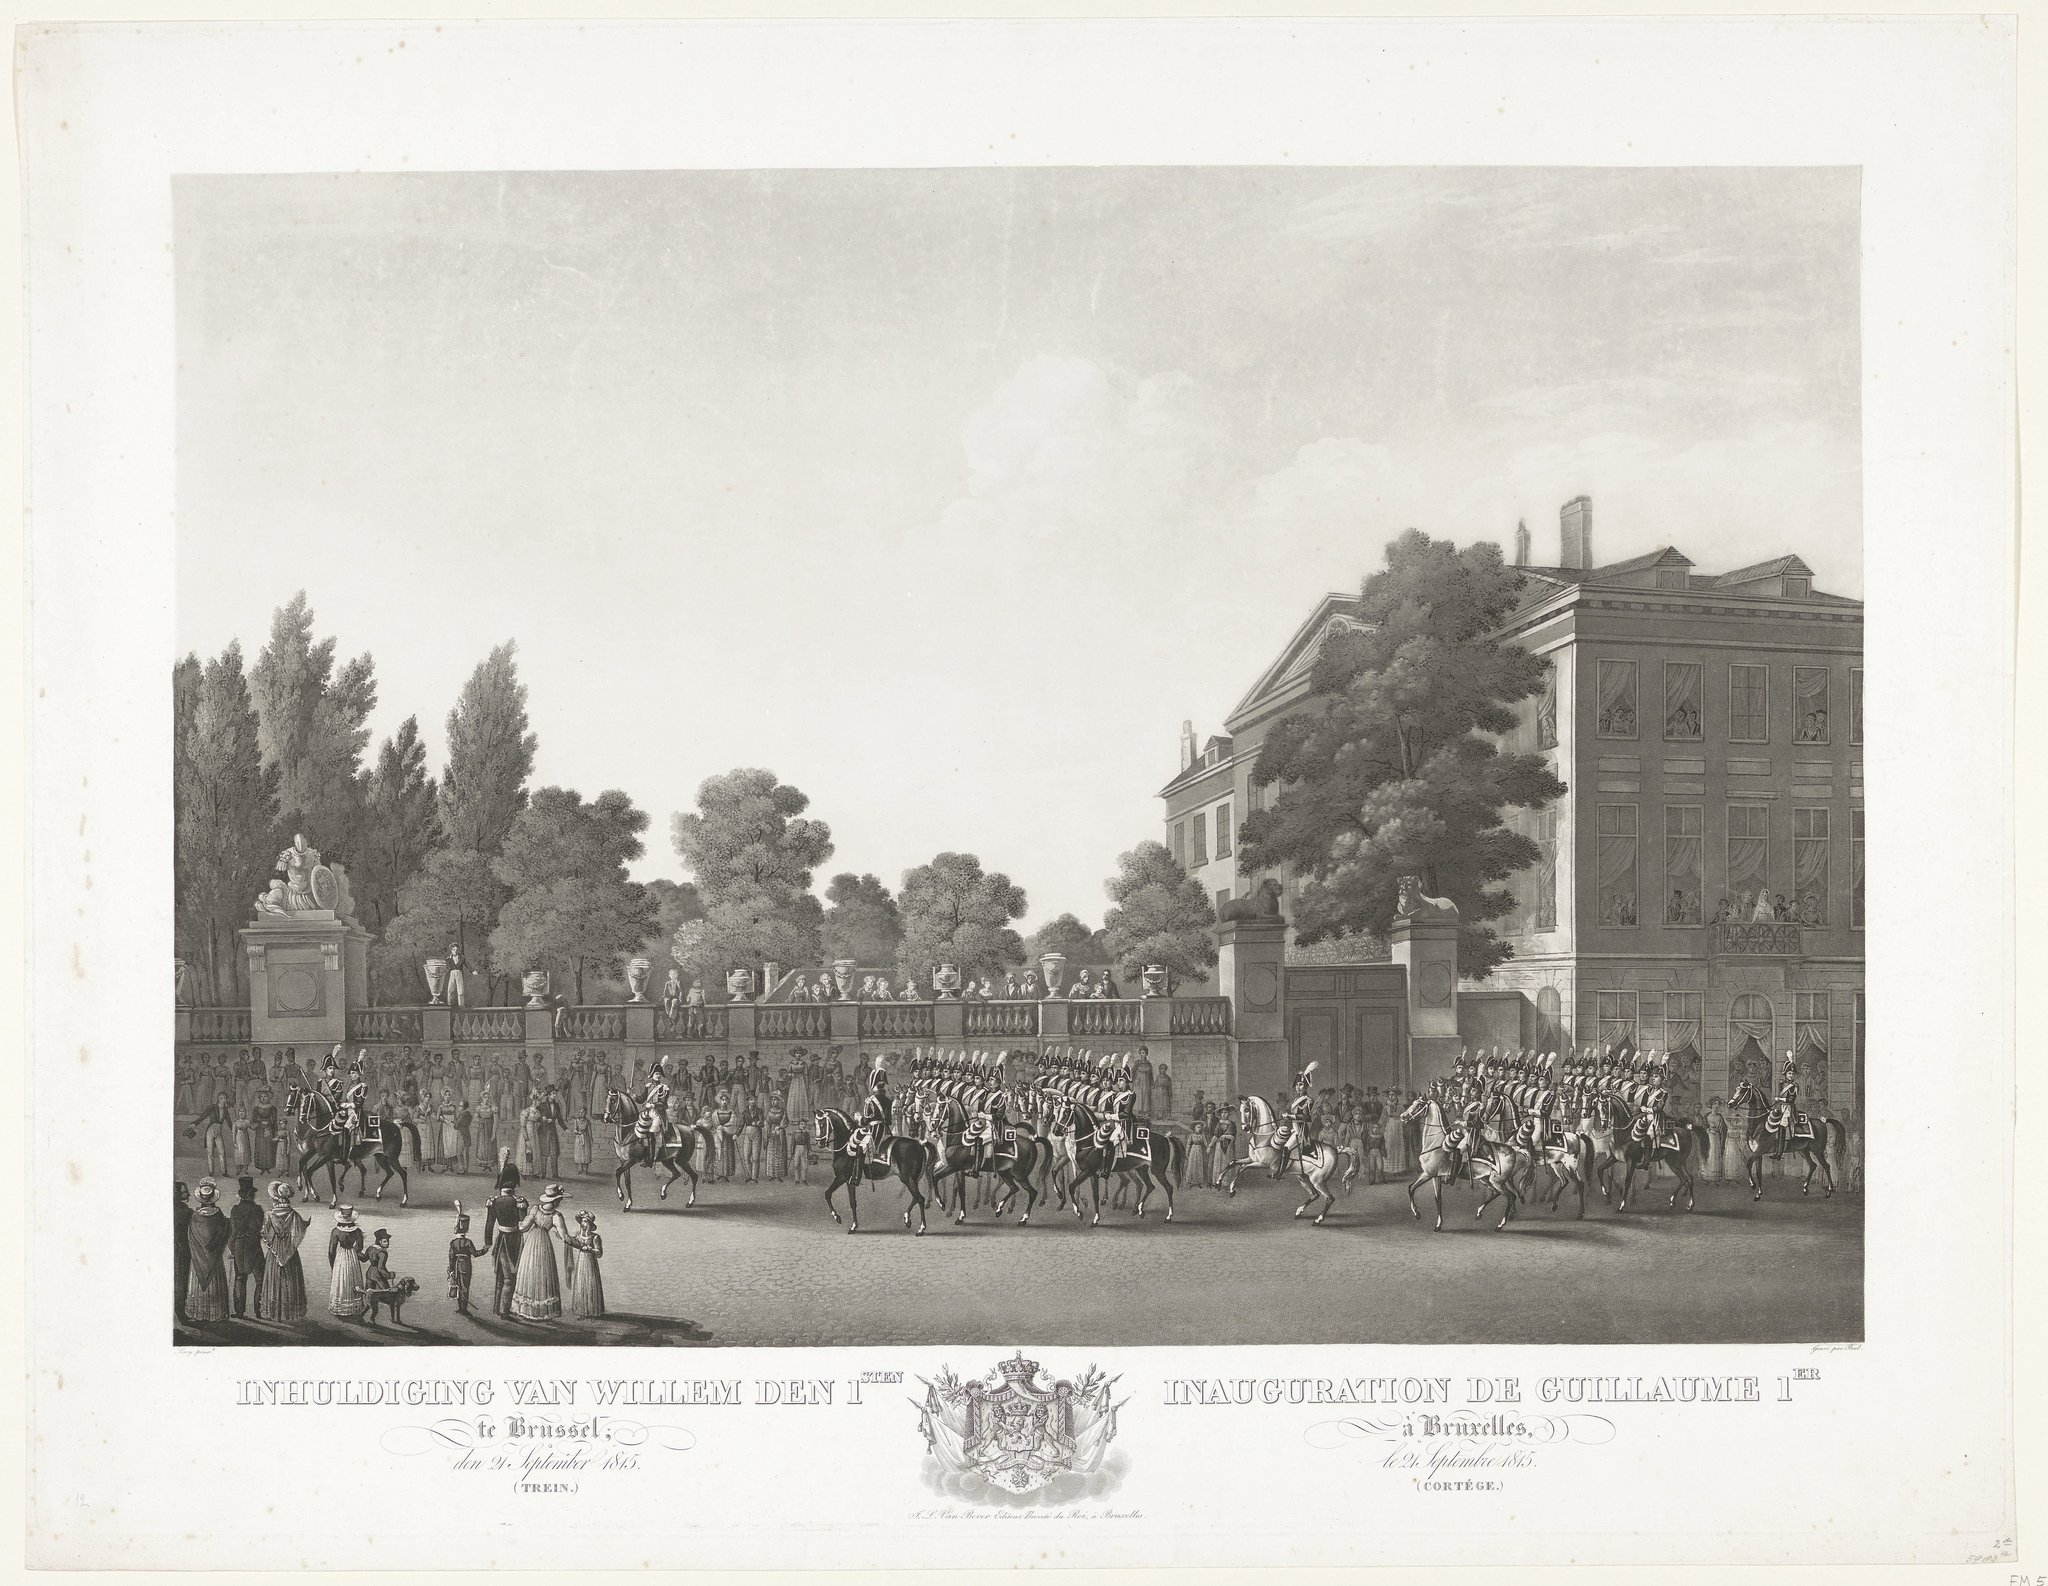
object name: print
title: Inhuldiging van Willem den 1sten te Brussel, den 21 September 1815 (Trein.) / Inauguration de Guillaume 1er à Bruxelles, le 21 Septembre 1815. (Cortège.)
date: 1825-1826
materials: paper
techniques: aquatint, etching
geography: brussels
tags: the hague, berlin, william i of the netherlands, triumphal entry and public reception, pageant, 'entrée solennelle', 'joyeuse entrée', brussels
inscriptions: workshop stamp: ‘JLVB’, collector's mark: Lugt 2228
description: Plechtige intrede van de stoet voor de inhuldiging van koning Willem I te Brussel op 21 september 1815. Cavalerie sluit de stoet af. Onderaan de titels in het Nederlands en Frans gescheiden door het wapen van koning Willem I. Onderdeel van een serie platen van de aankomst en inhuldiging van Willem I in Brussel.